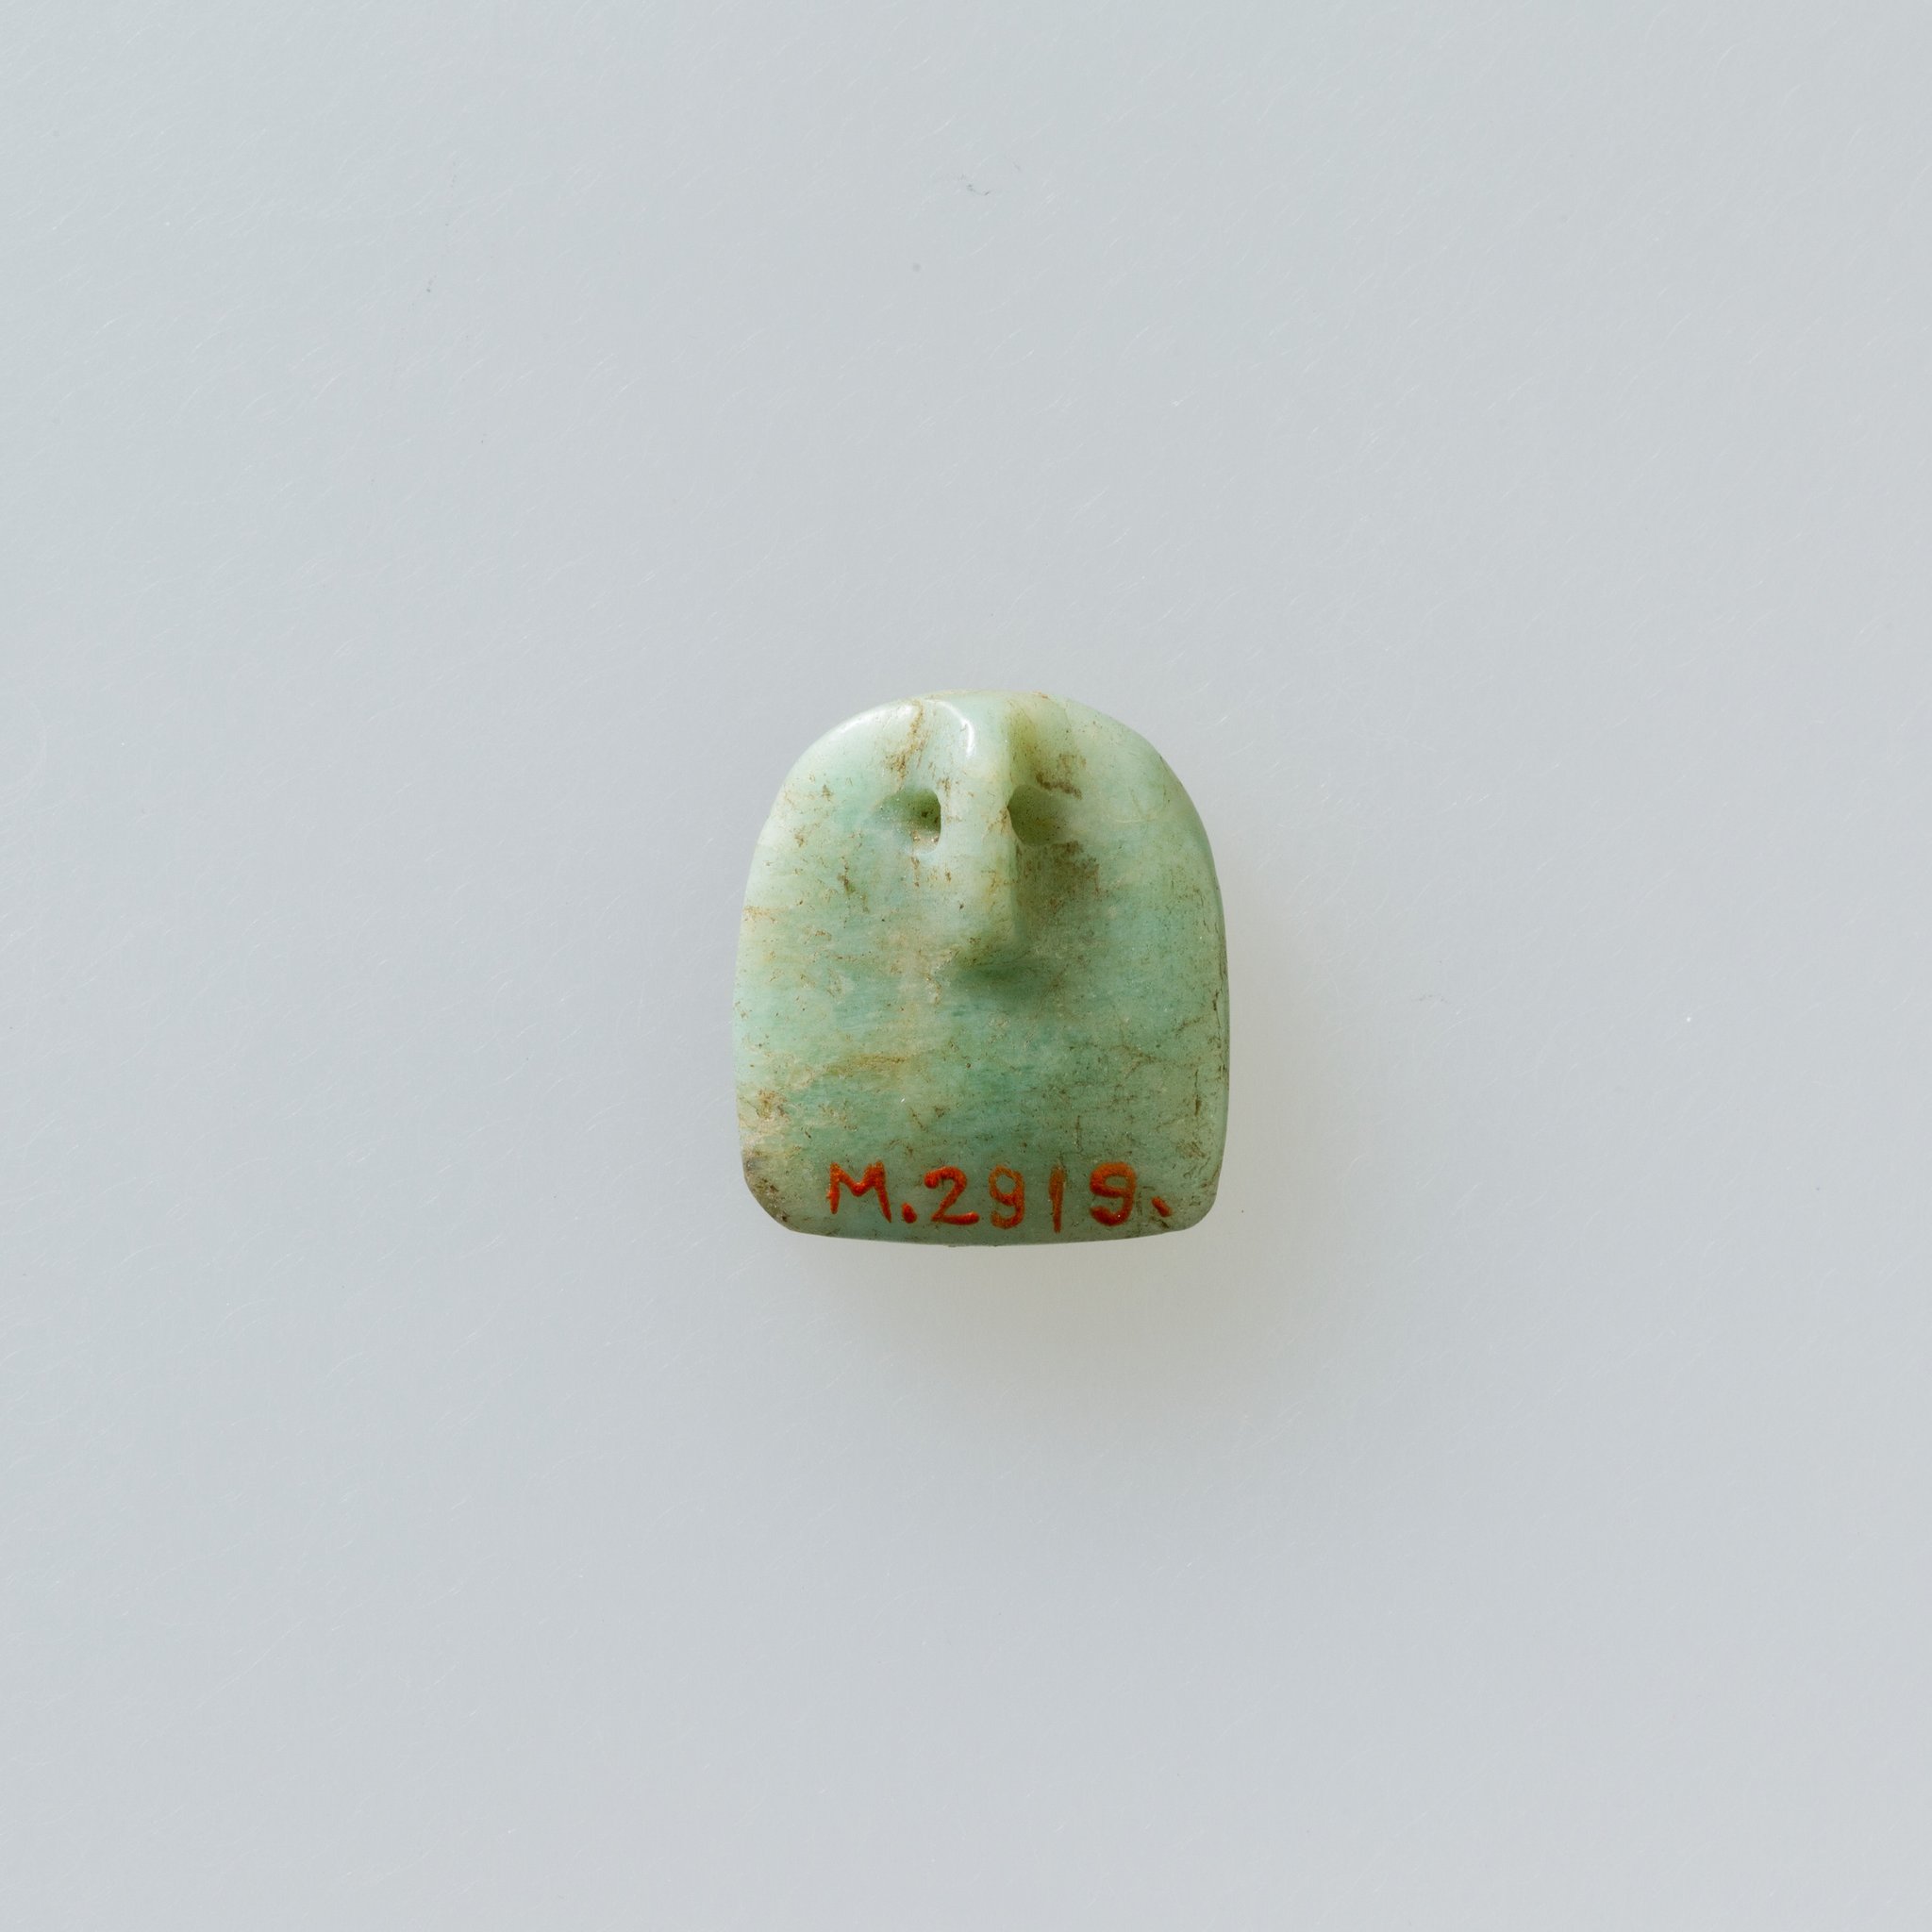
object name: pendant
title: Shield shaped attachment or amulet with four holes connected by diagonals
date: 332 BCE-364 CE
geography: egypt